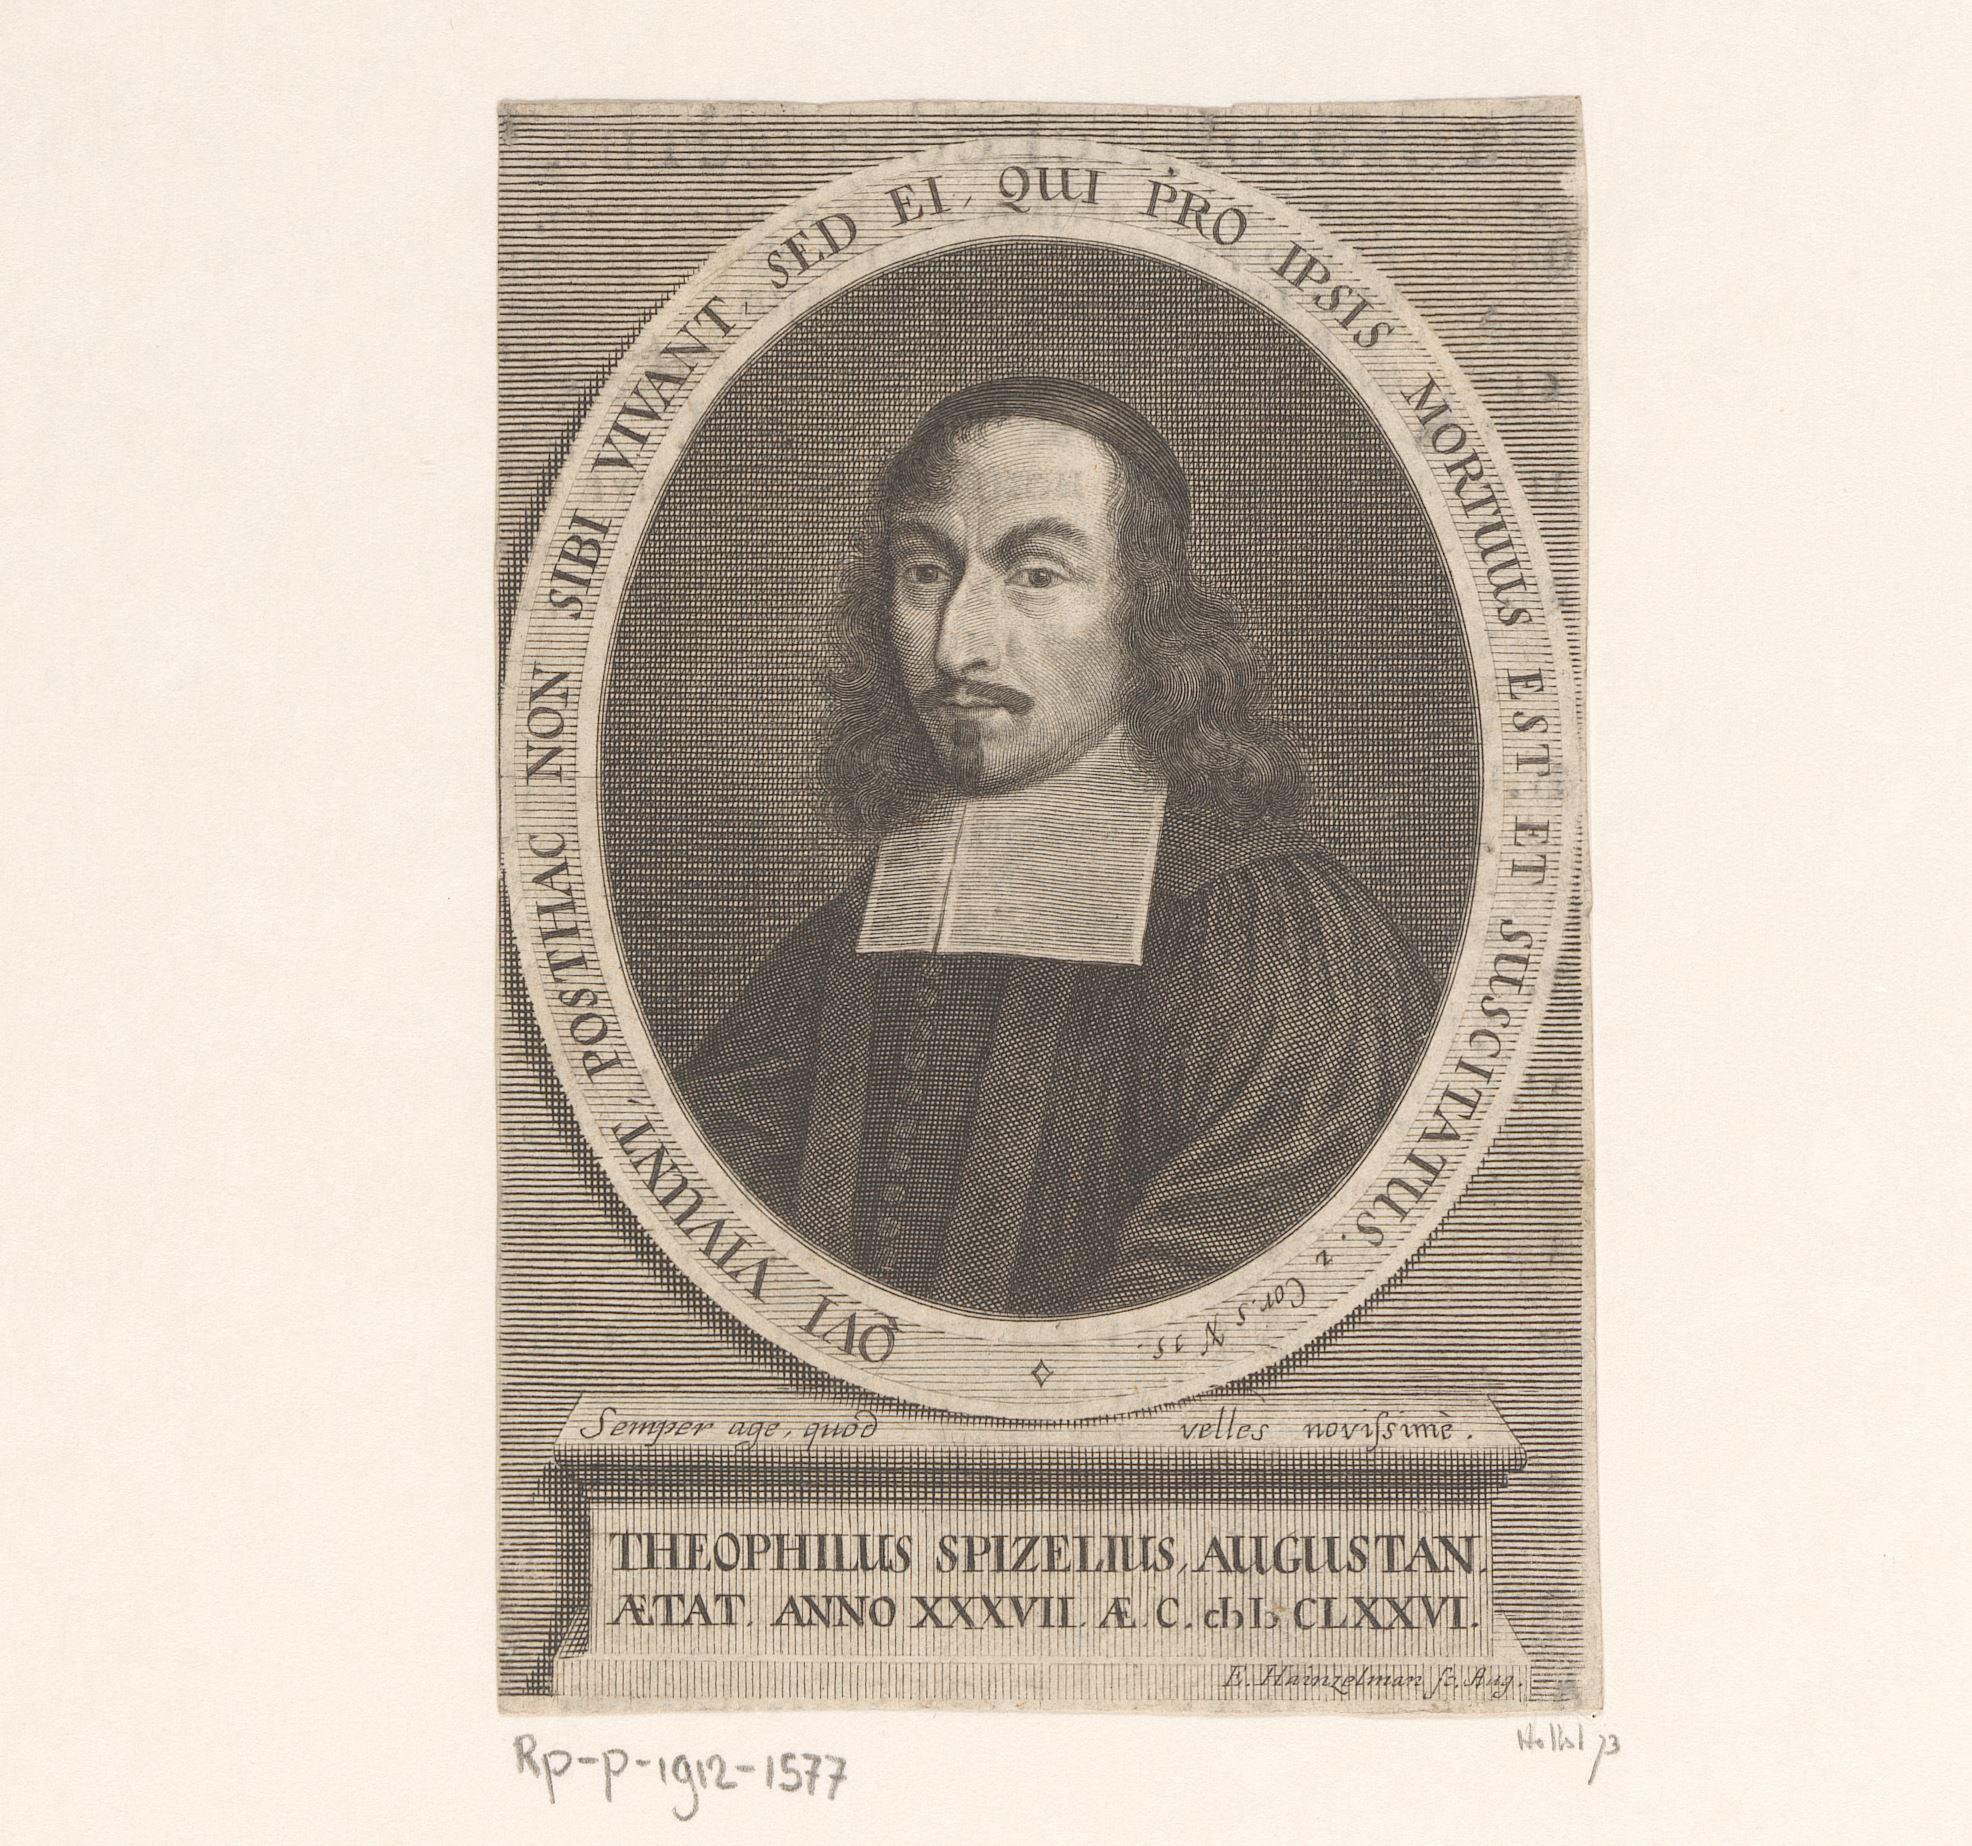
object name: book illustration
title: Portret van Gottlieb Spitzel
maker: elias hainzelmann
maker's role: artist, print maker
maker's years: 1640-1693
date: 1691-1693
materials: paper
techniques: engraving, letterpress printing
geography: augsburg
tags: augsburg, theologian, historical persons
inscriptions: collector's mark: Lugt 2228